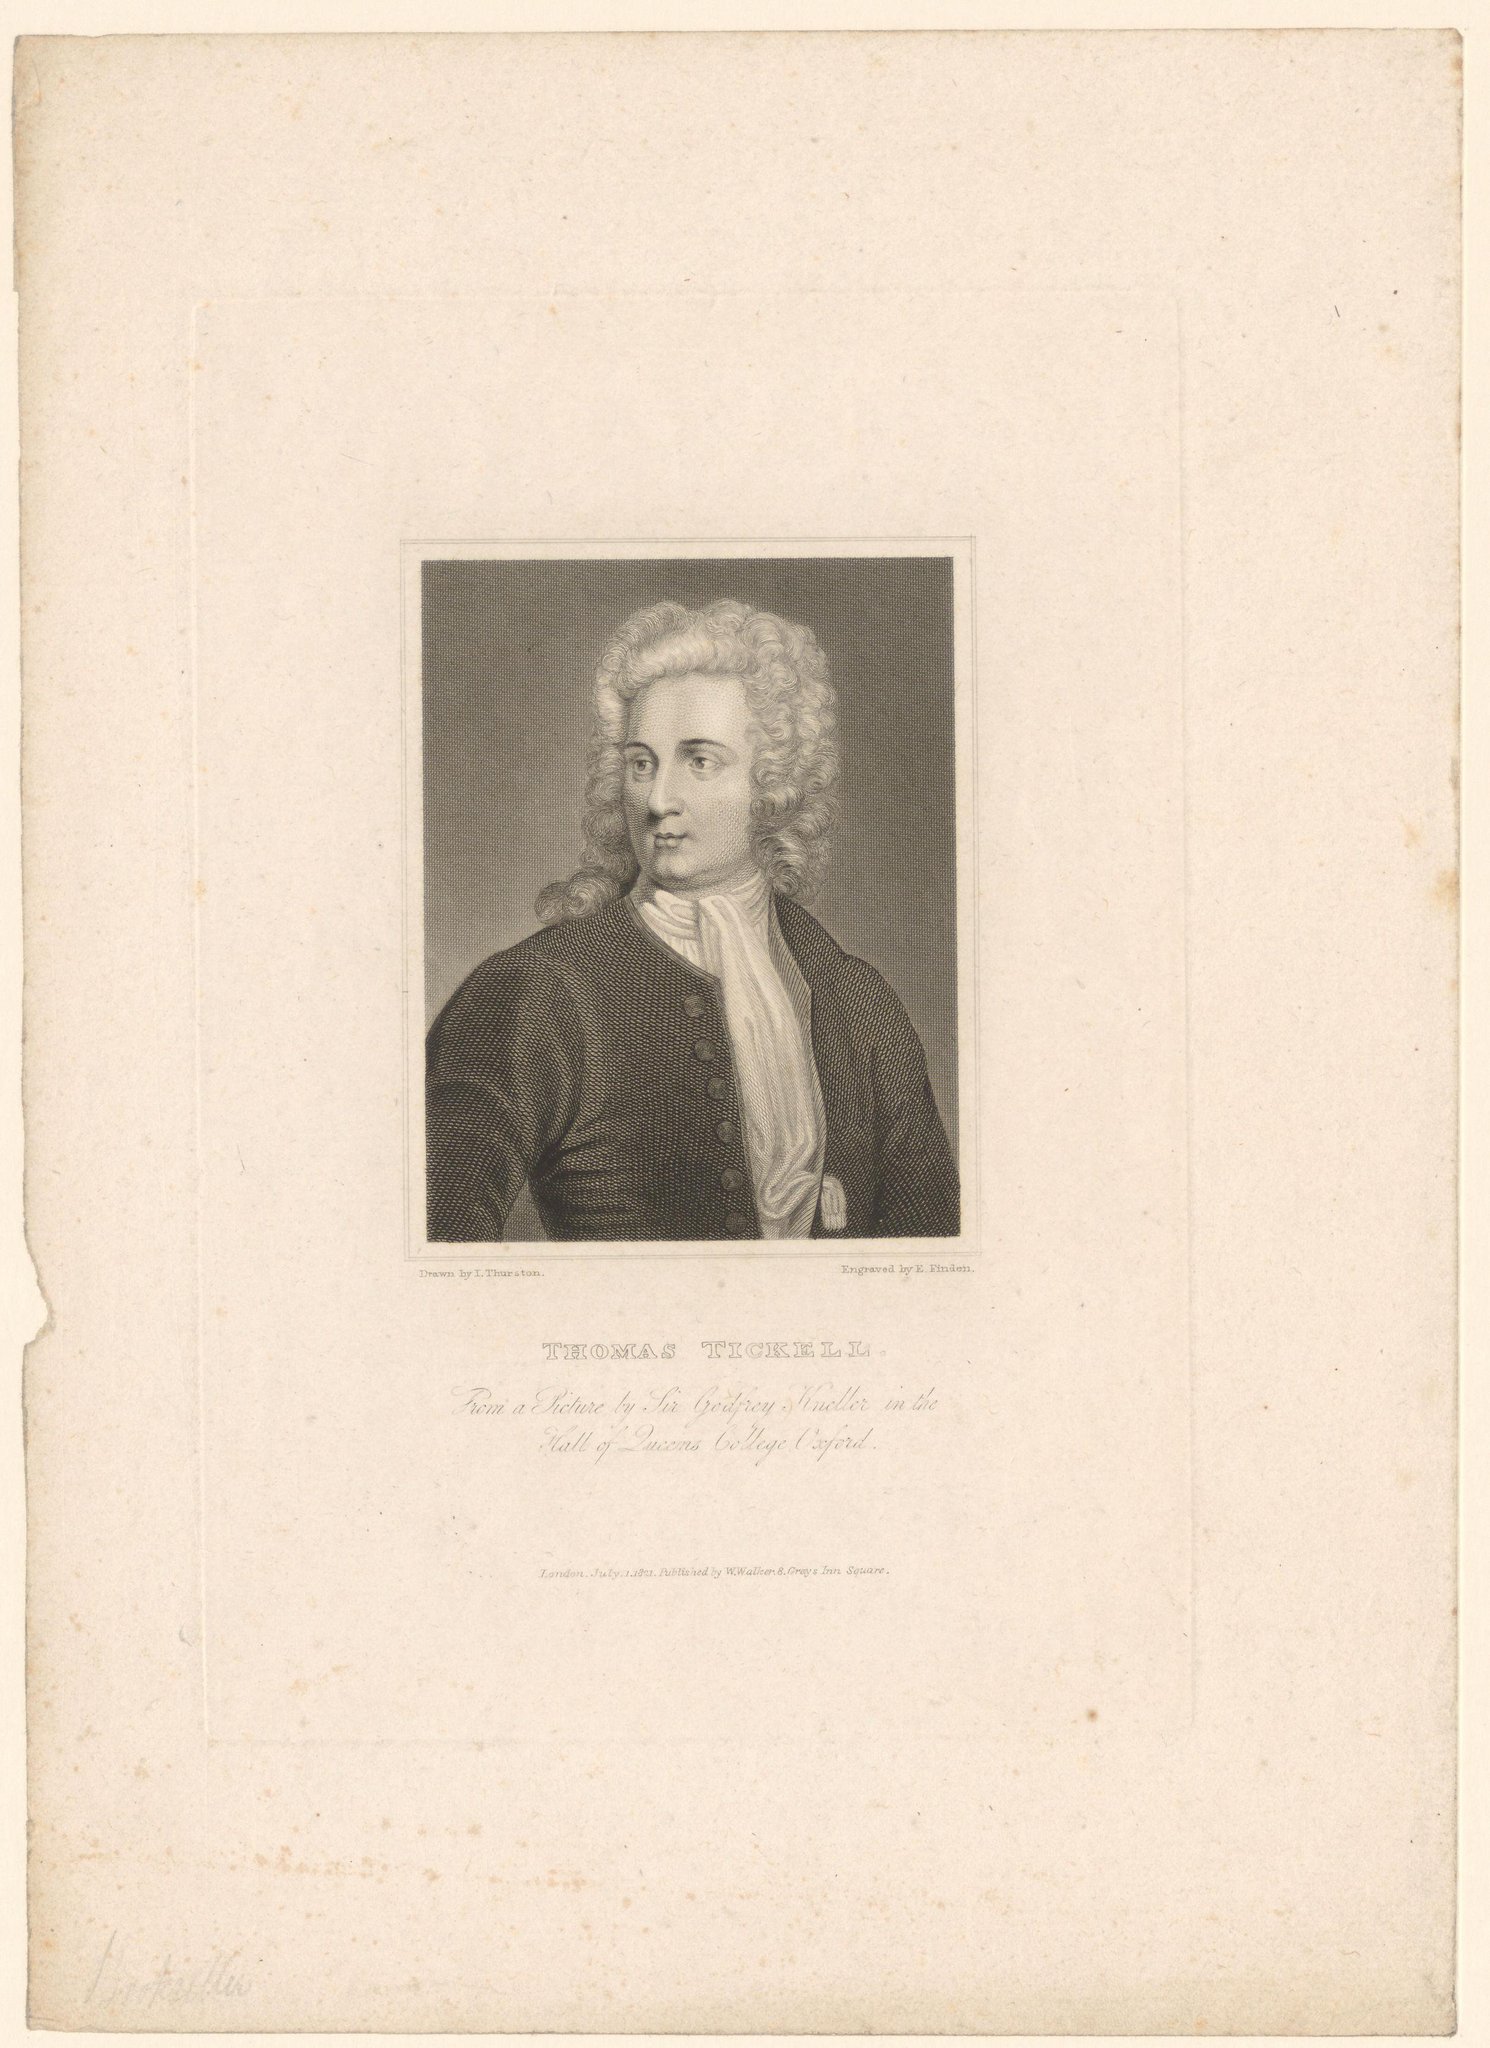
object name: print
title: Thomas Tickell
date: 1807-1821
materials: paper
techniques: etching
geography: london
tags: historical persons, portrait of a writer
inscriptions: collector's mark: Lugt 2228